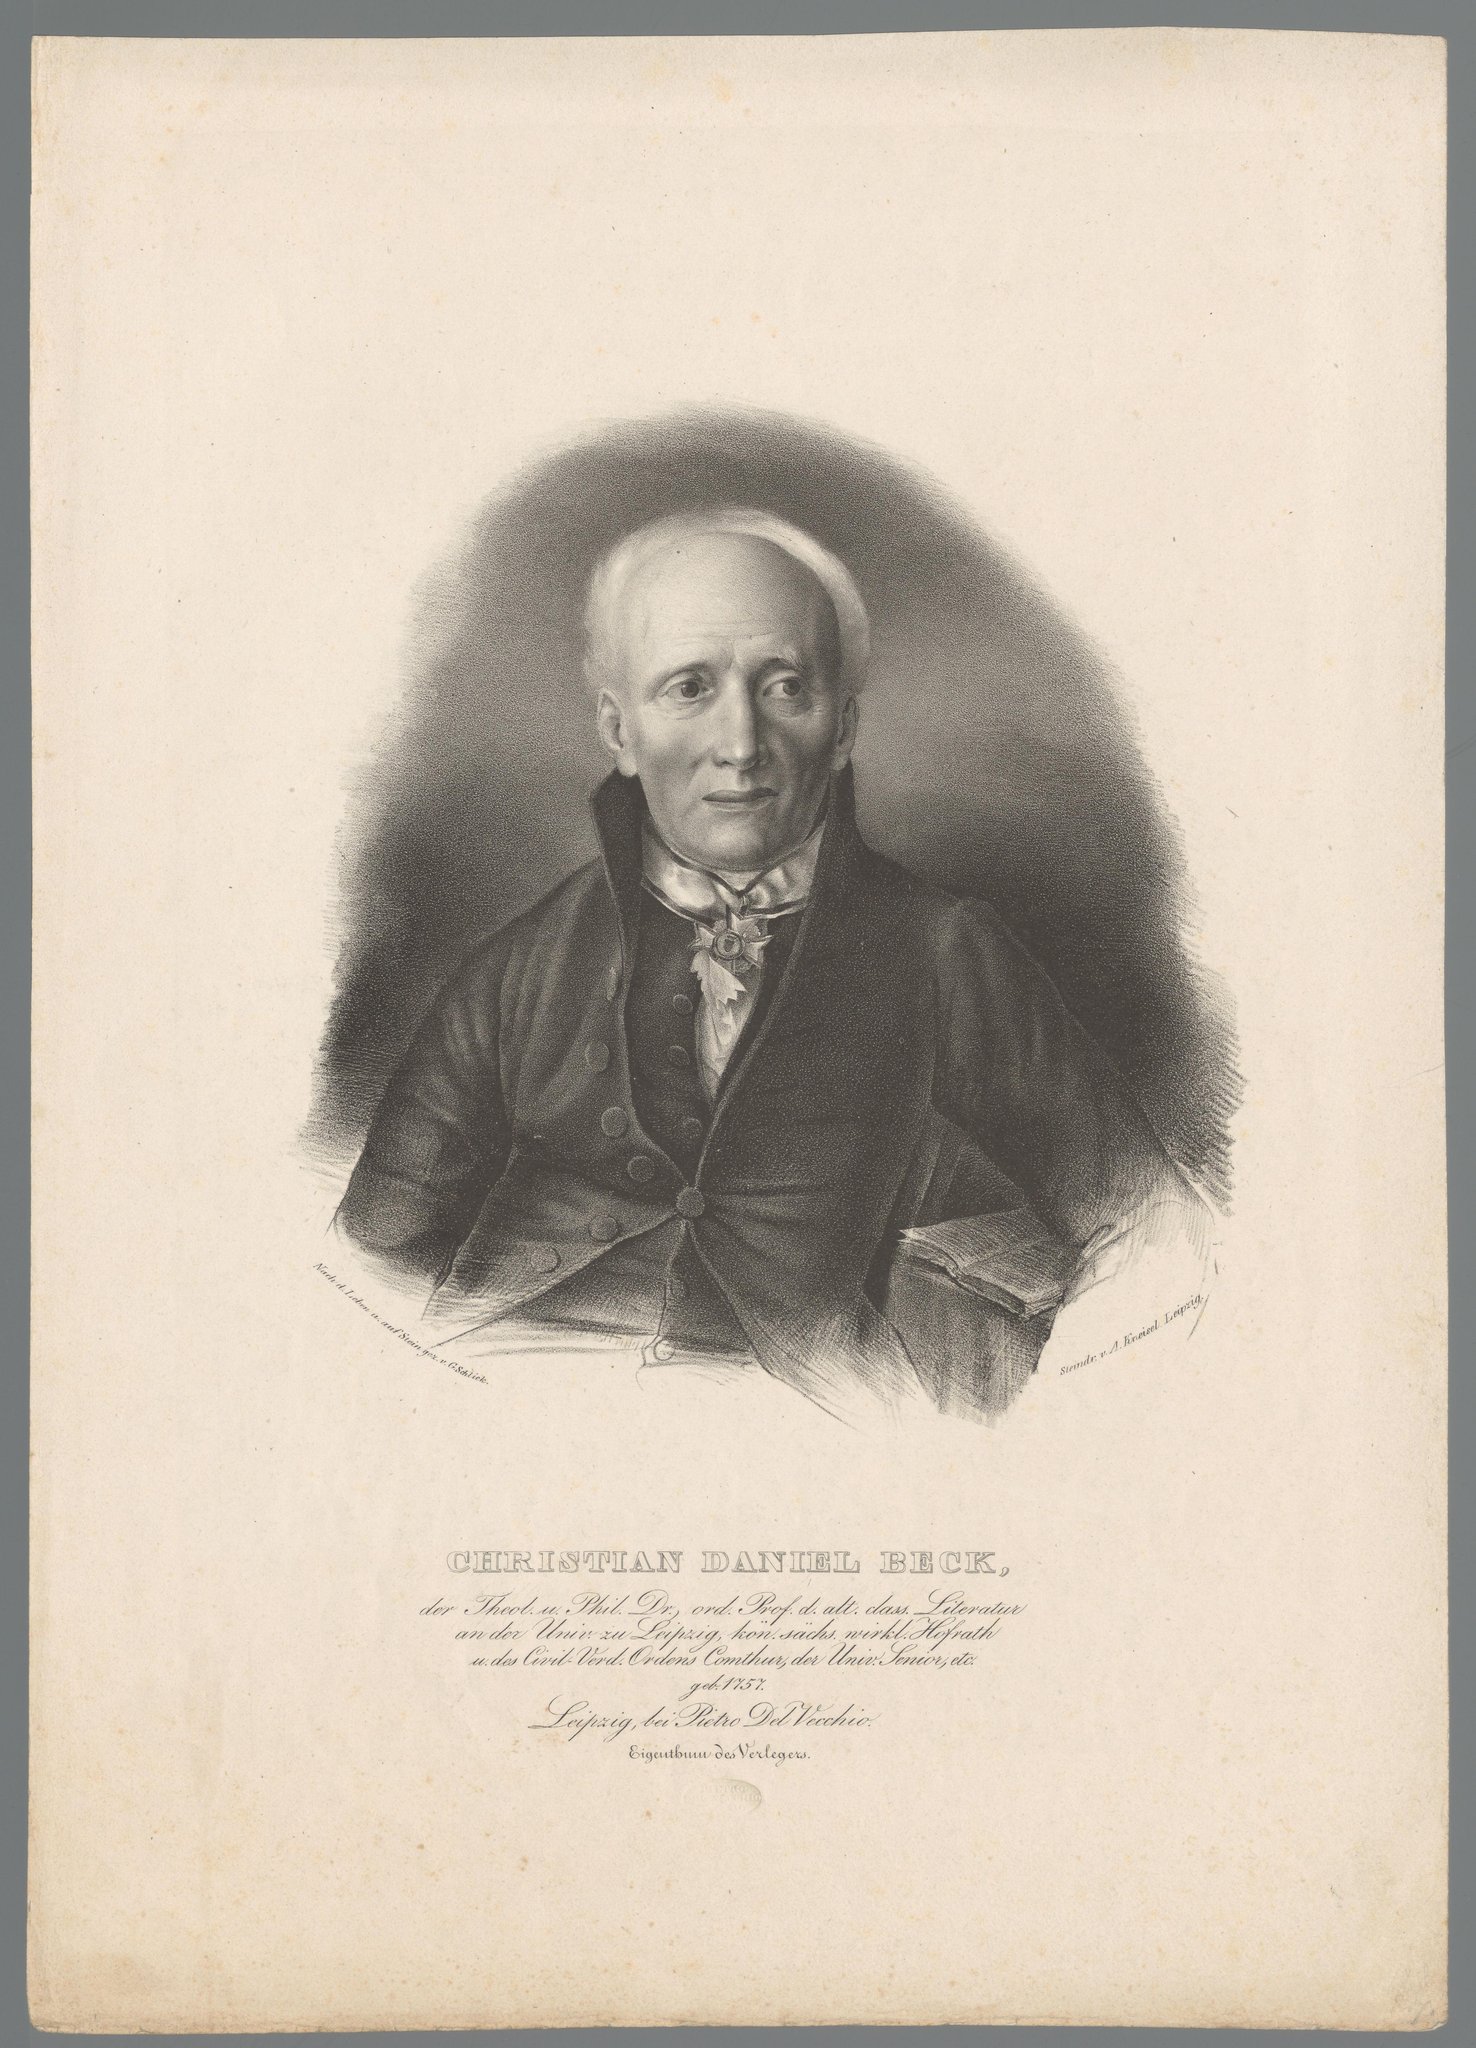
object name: print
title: Portret van Christian Daniel Beck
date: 1814-1869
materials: paper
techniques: lithograph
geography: leipzig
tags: theologian, historical persons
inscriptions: check stamp: ‘Pietro Del Vecchio Leipzig’, collector's mark: Lugt 2228